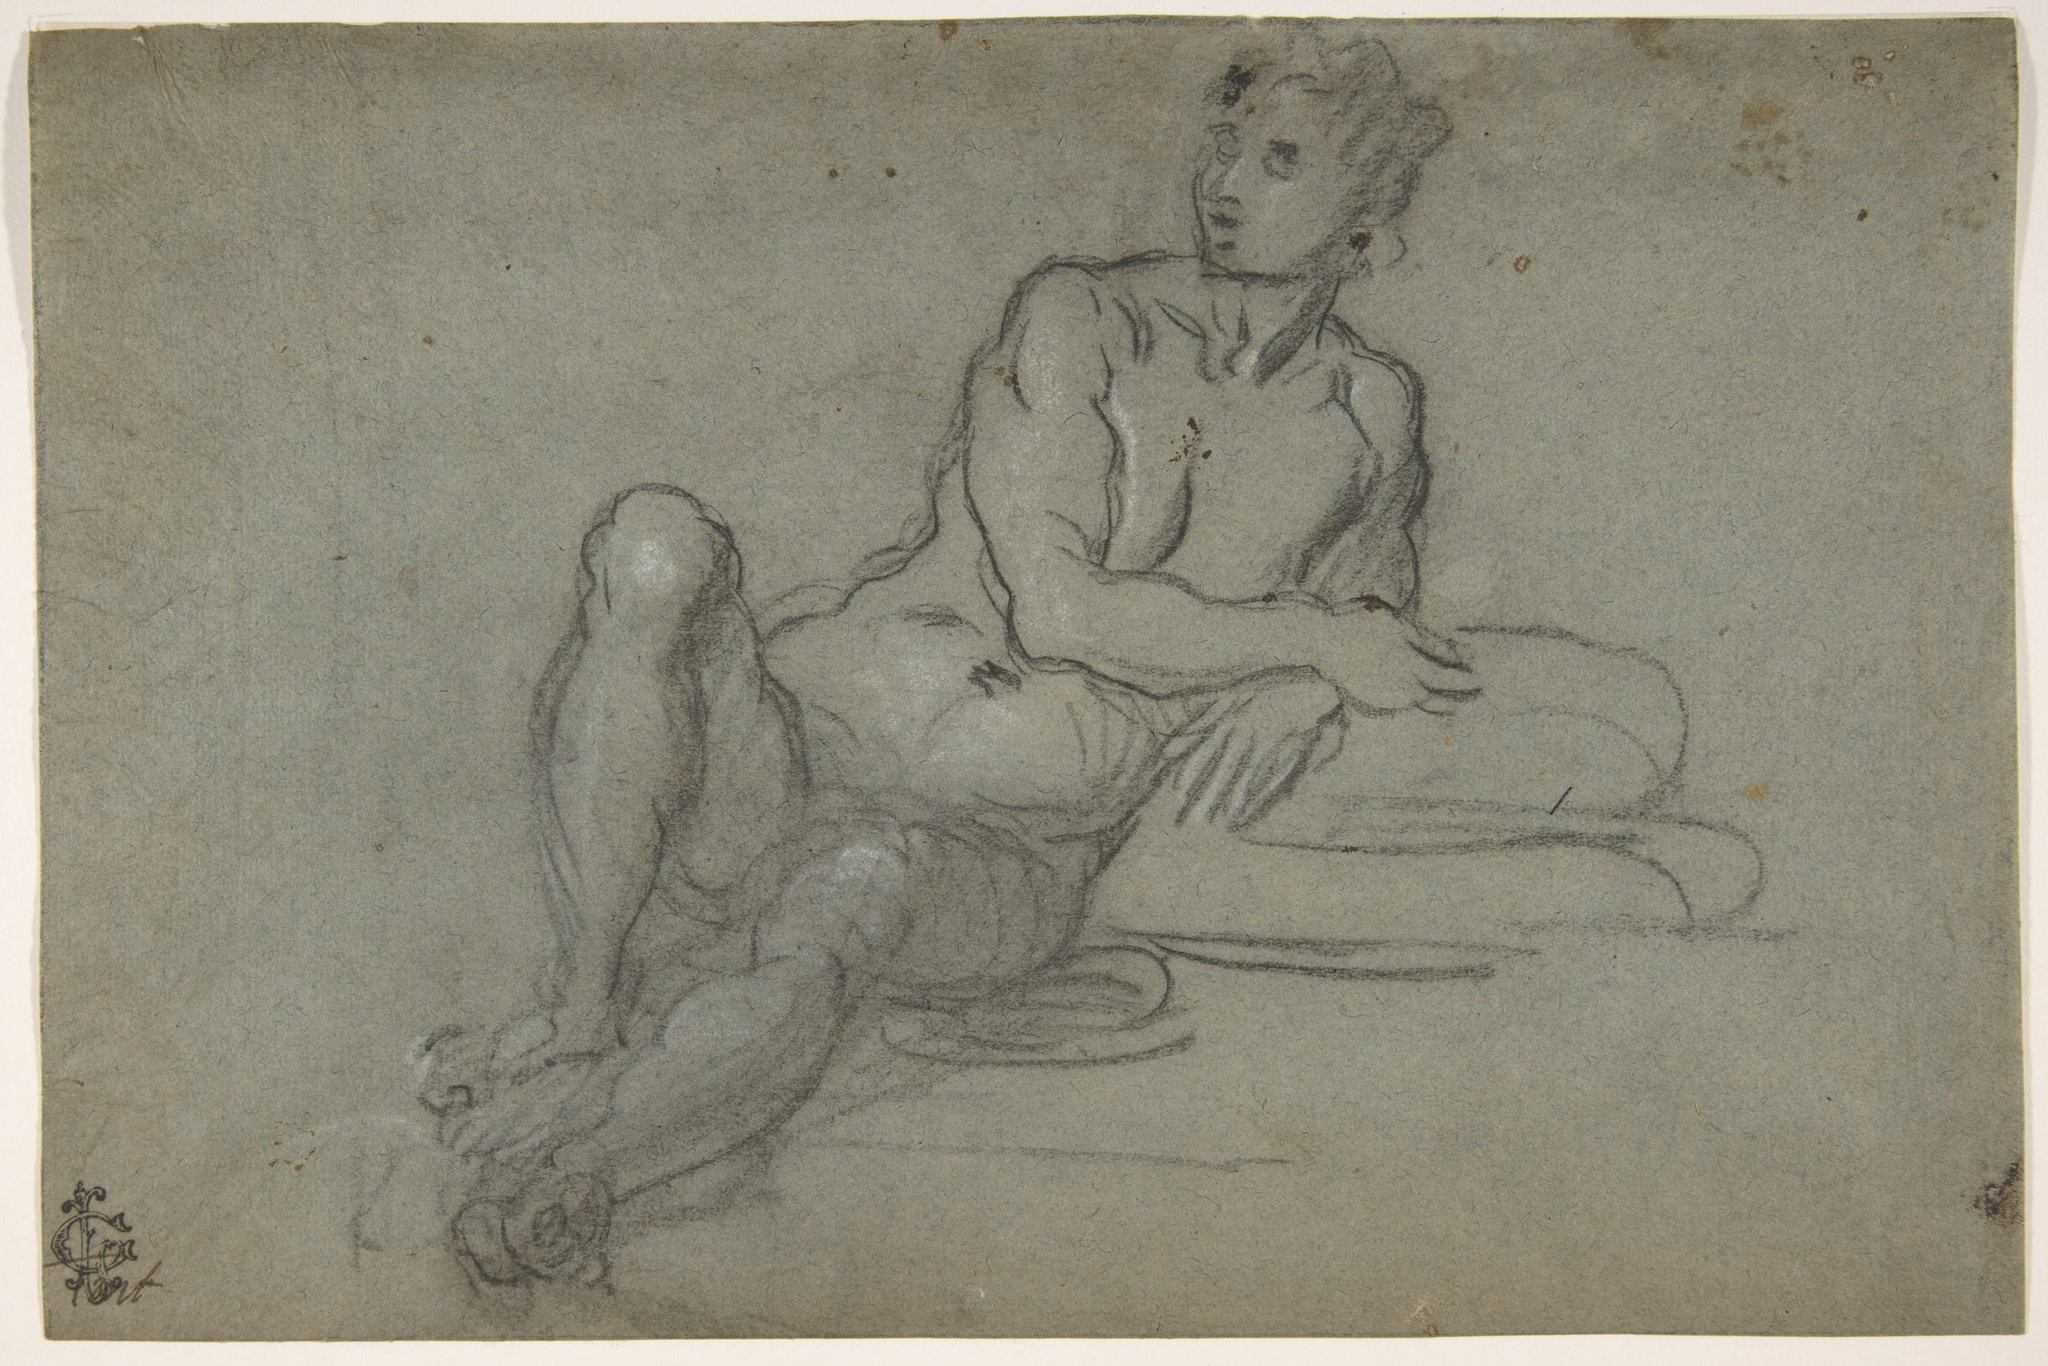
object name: drawing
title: Reclining Female Nude Figure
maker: domenico tintoretto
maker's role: artist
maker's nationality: italian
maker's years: 1560-1635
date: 1560-1635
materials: chalk, paper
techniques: highlighting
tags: female nudes